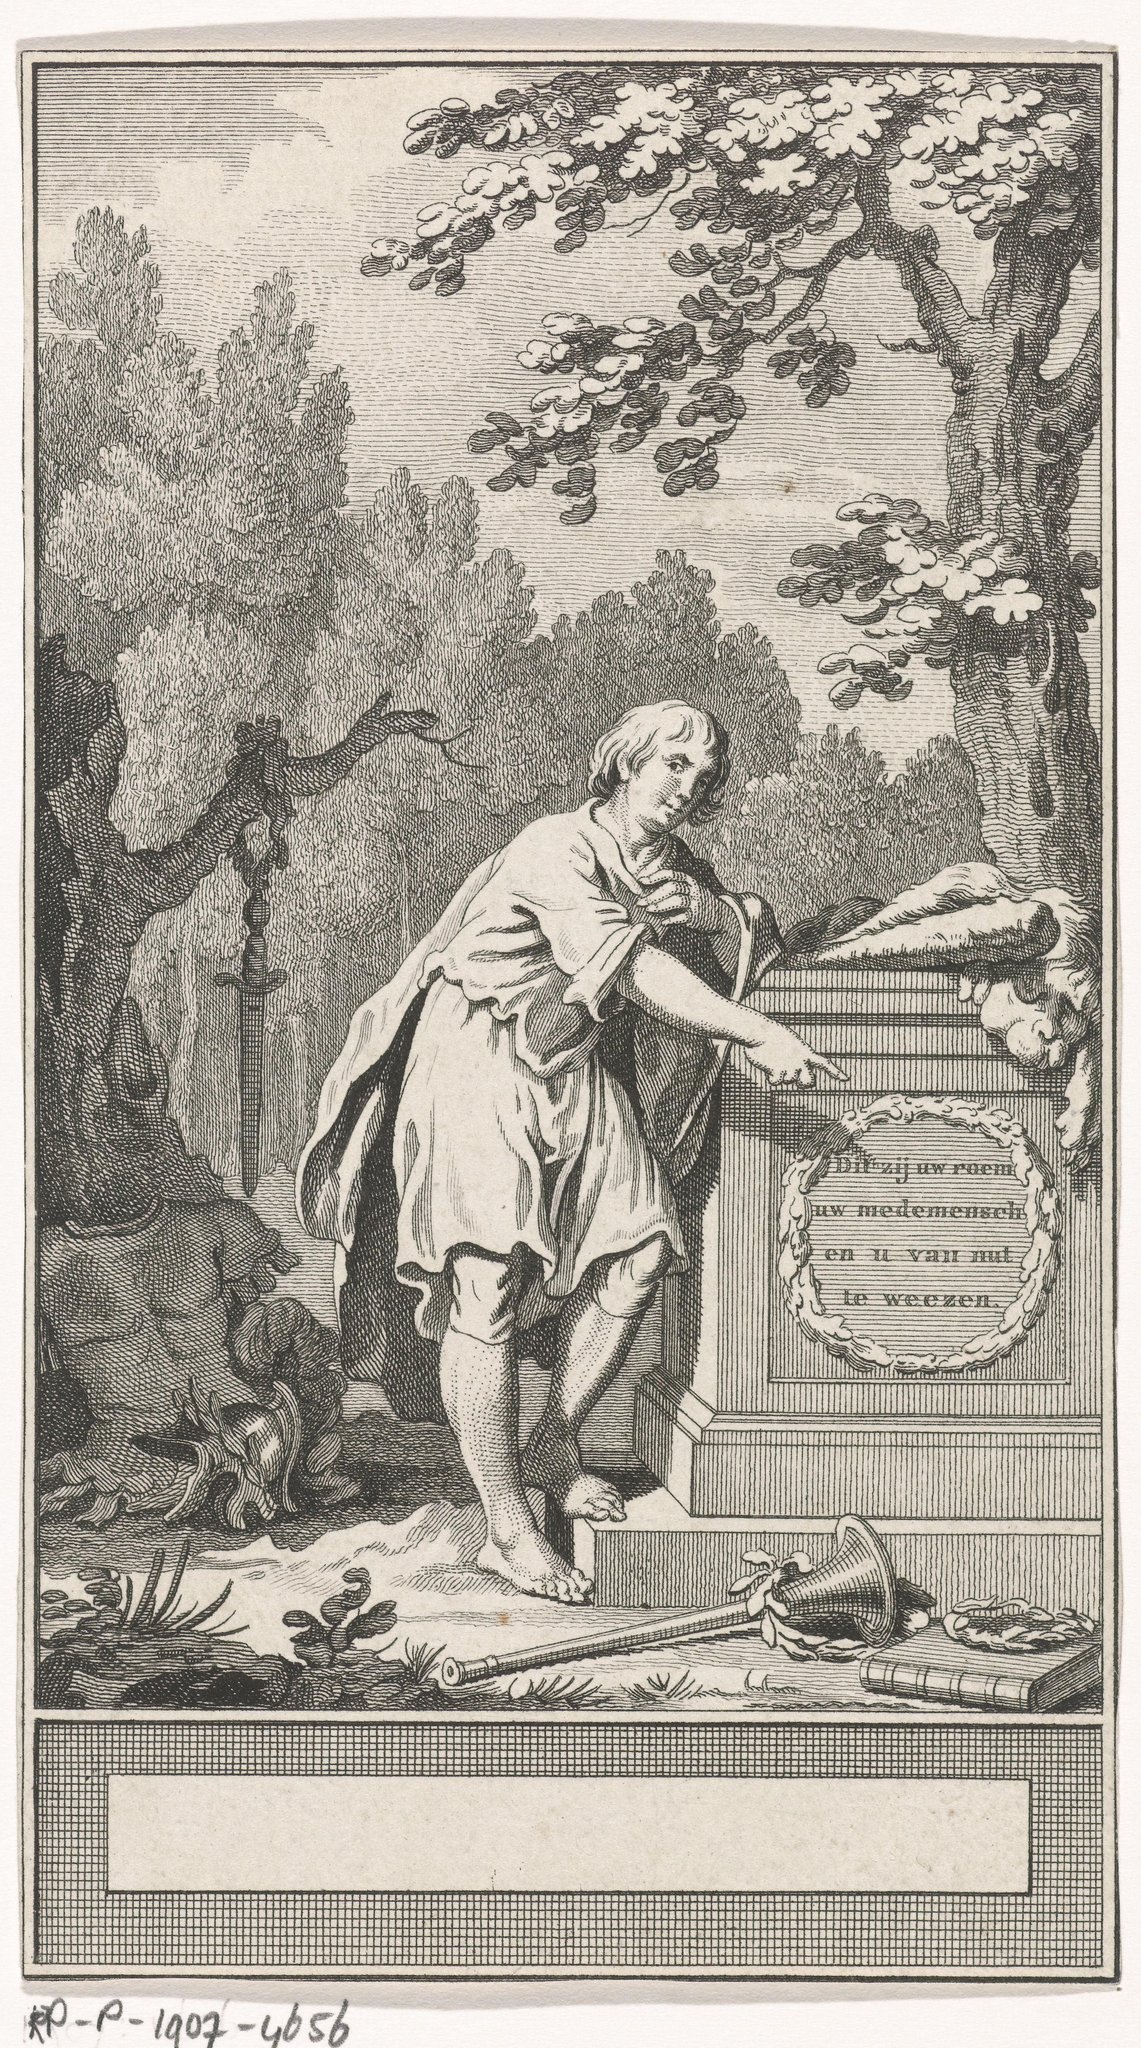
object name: print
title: Roem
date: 1778-1785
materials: paper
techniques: etching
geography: amsterdam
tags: crowning with laurel (+ variant), attributes of hercules, fame; 'fama', 'fama buona', 'fama chiara' (ripa)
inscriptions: collector's mark: Lugt 2228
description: Latere staat bij: Gellert, Christian Fürchtegott. Fabelen en vertelsels. 3 dln. Amsterdam: Pieter Meyer, 1772-1774. De prenten bij deze publicatie werden later uitgegeven. De exemplaren uitgegeven door de weduwe Jacobus Loveringh & Johannes Allart tussen 1777 en 1778, de exemplaren uitgegeven door alleen Johannes Allart tussen 1778 en 1785.